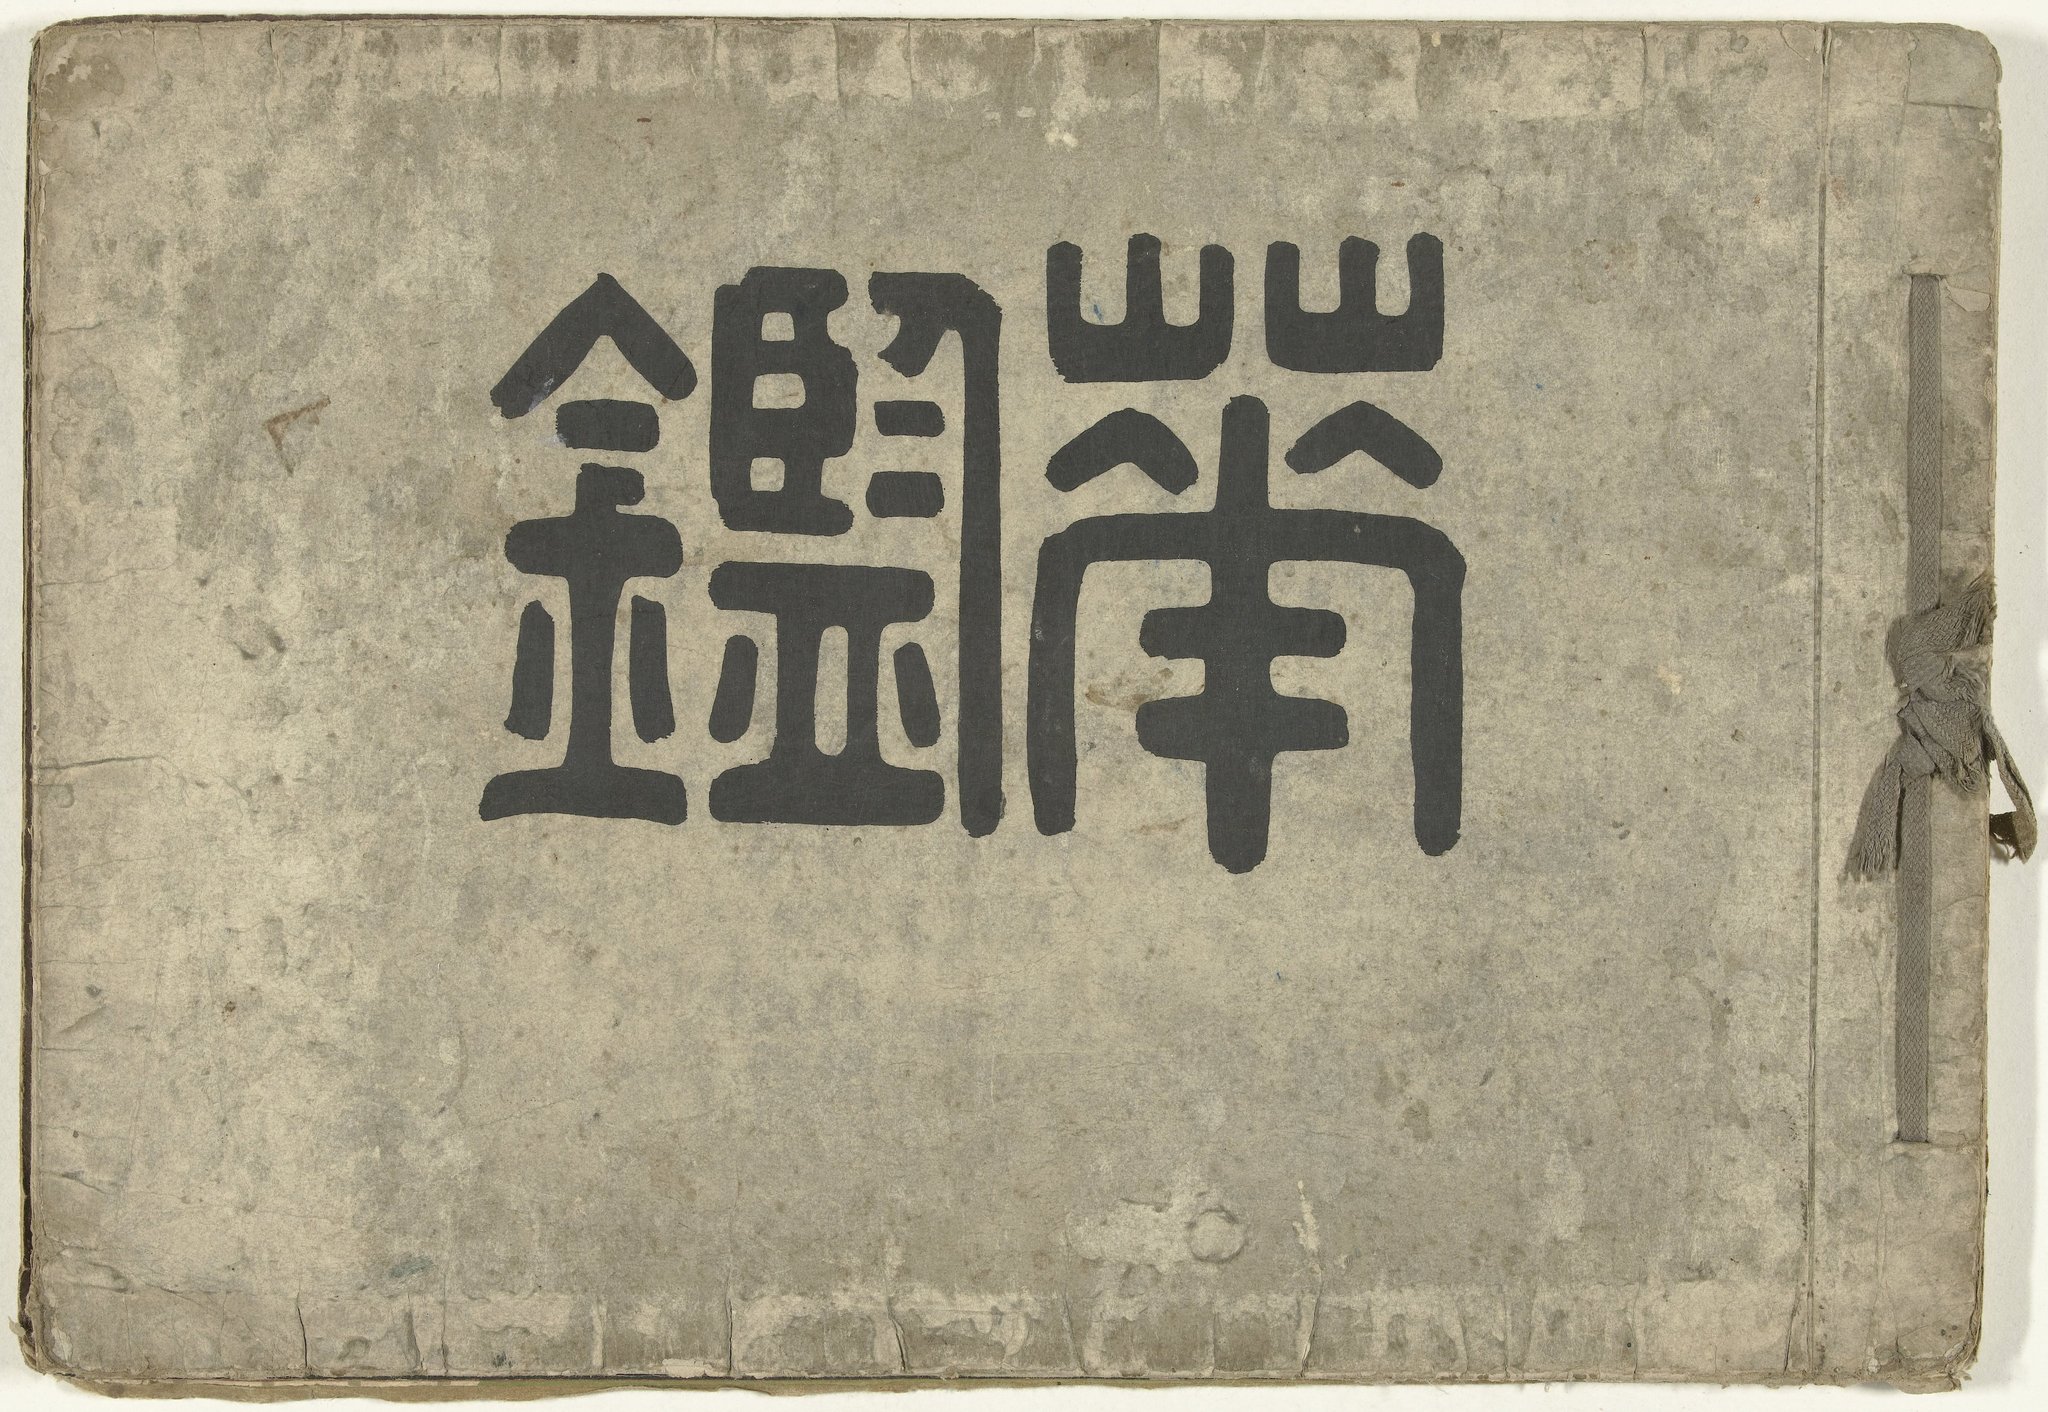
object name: book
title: Hana kagami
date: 1904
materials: paper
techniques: woodcut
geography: kyoto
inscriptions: date